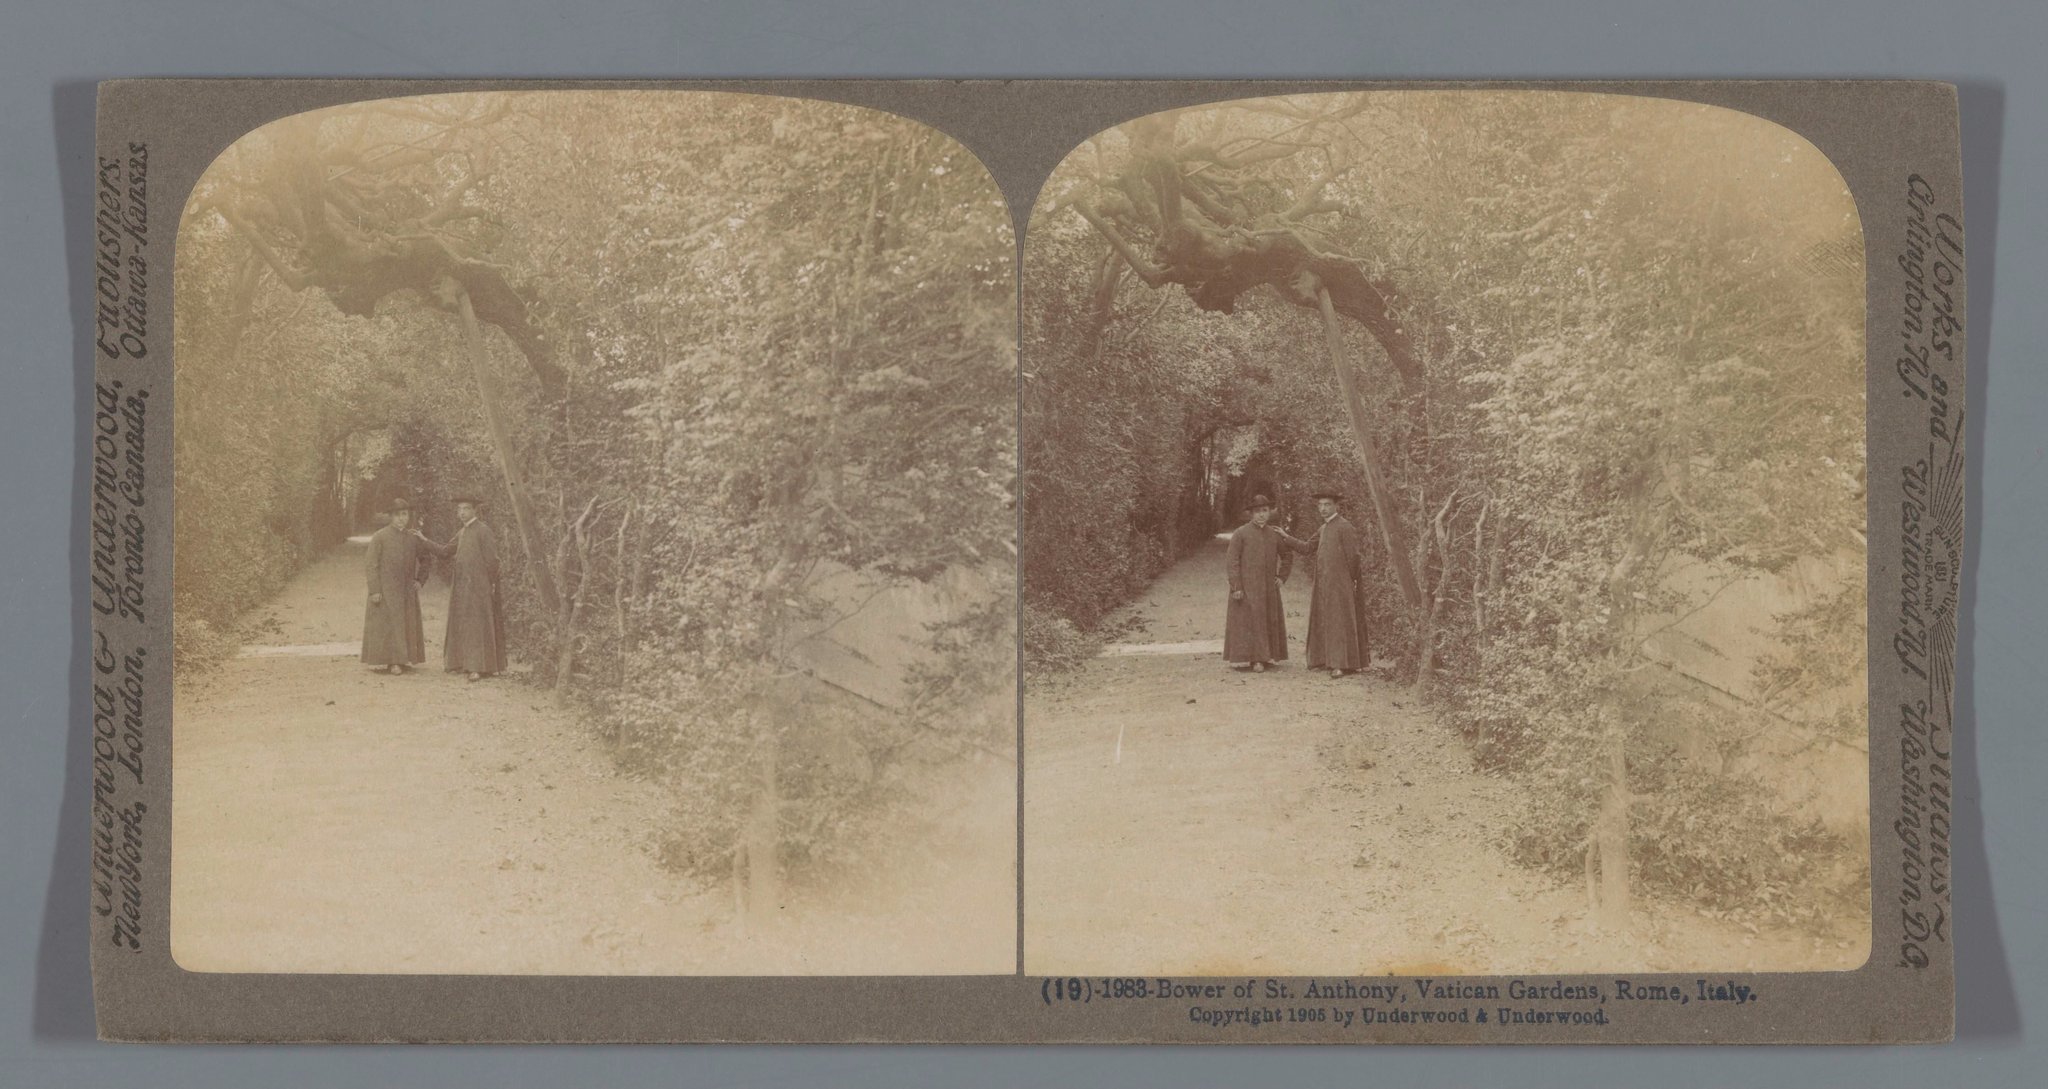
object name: stereograph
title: Bower of St. Anthony, Vatican Gardens, Rome, Italy.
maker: Anonymous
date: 1905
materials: cardboard, photographic support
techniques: albumen print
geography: new york city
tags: french or architectonic garden; formal garden, organization, functionaries and dignitaries in roman catholic church; clergy in general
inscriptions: name: ‘Underwood & Underwood Publishers New York, London, Toronto-Canada, Ottawa-Kansas.’, inscription: ‘Works and Studios Arlington, N.J. Westwood, N.J. Washington, D.C.’, number: ‘(19)-1983’